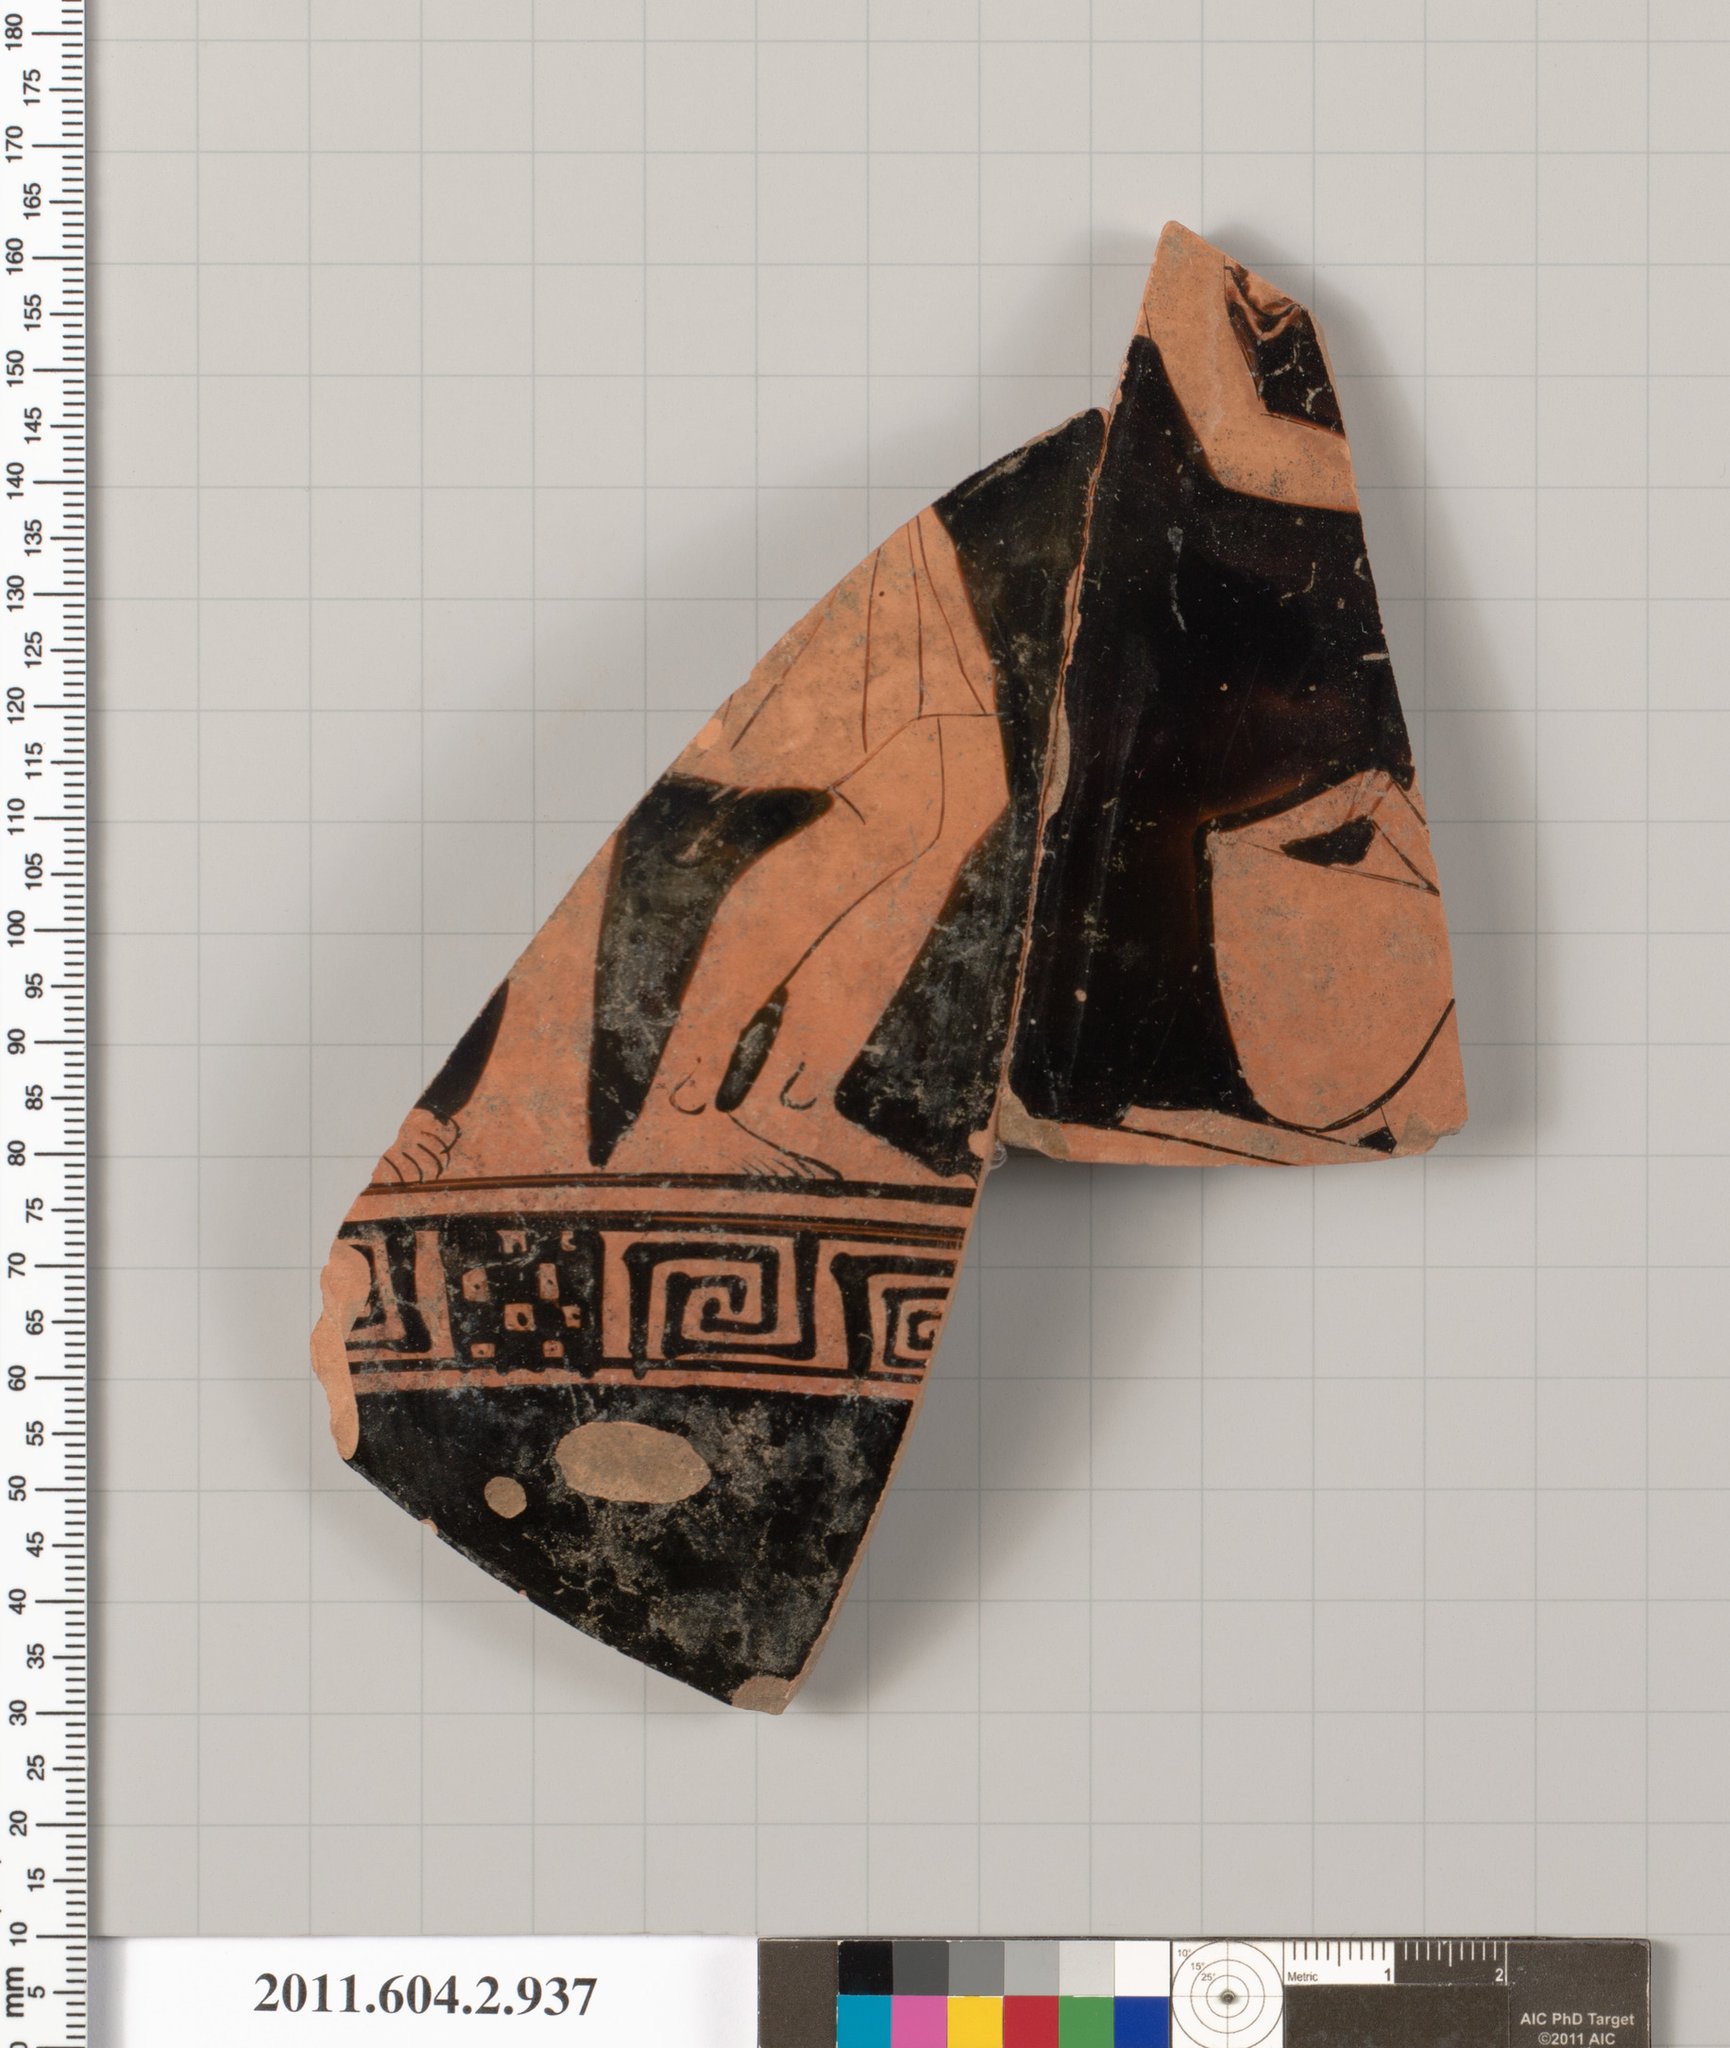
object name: bell krater fragment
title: Terracotta fragment of a bell-krater (bowl for mixing wine and water)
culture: greek, attic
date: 467-435 BCE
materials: terracotta